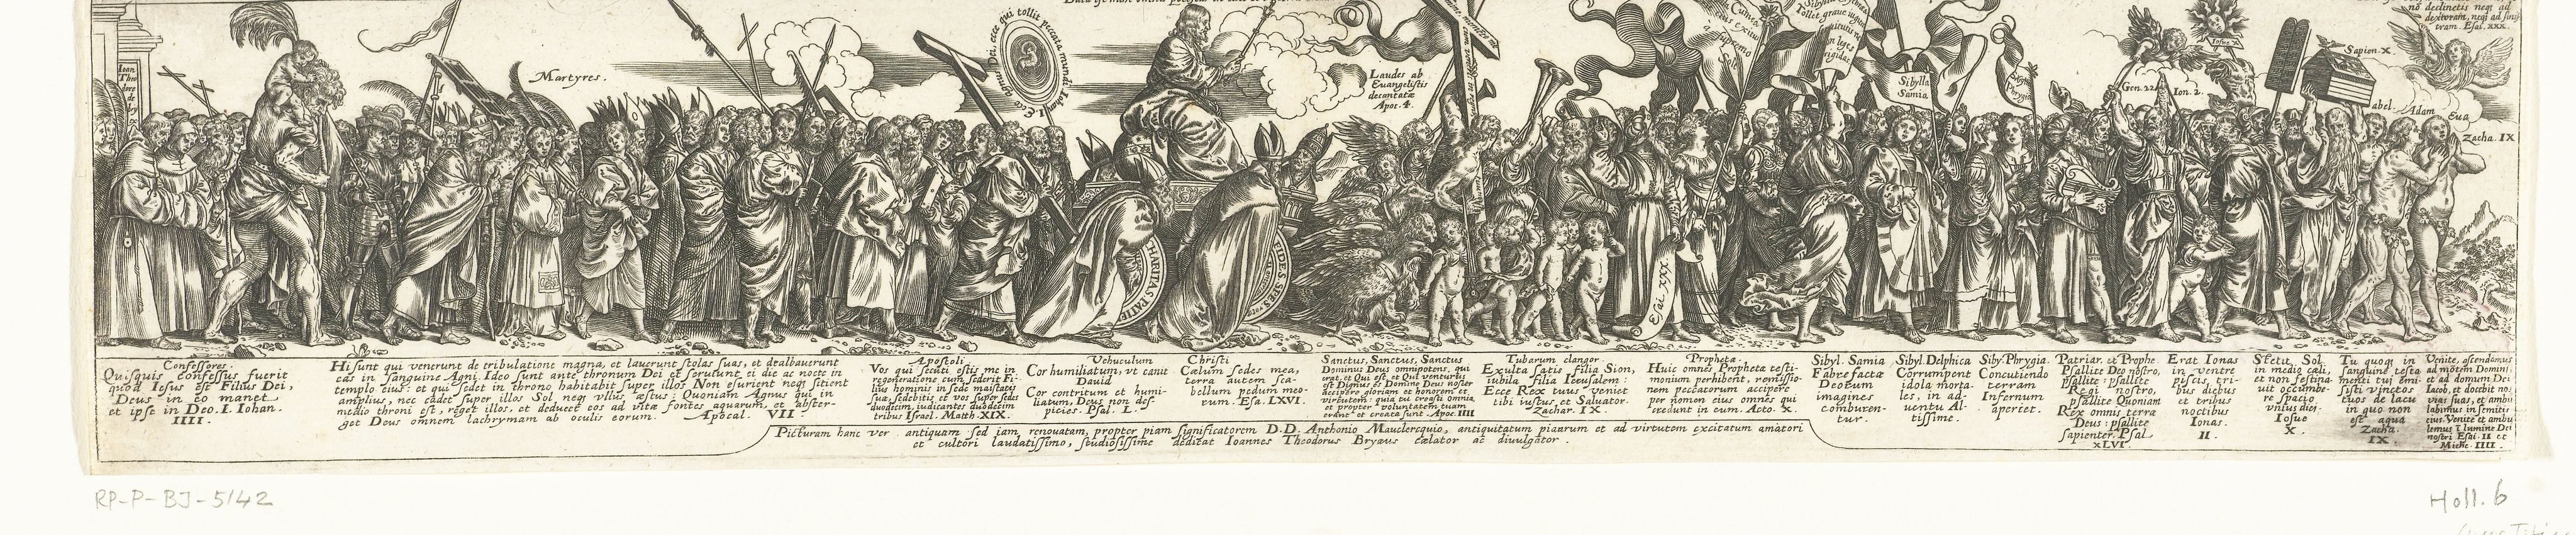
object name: print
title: De triomf van Christus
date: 1581-1623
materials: paper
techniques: engraving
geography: germany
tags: adam and eve (not in biblical context), triumphant christ, e.g. on triumphal chariot, groups of prophets, usually holding books or scrolls (isaiah, jeremiah, ezekiel, daniel, hosea, joel, amos, obadiah, jonah, micah, nahum, habakkuk, zephaniah, haggai, zechariah, malachi)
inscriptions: collector's mark: Lugt 240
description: Triomfstoet waarin Christus zit op een zegewagen, die wordt geduwd door de vier kerkvaders. De stoet wordt geopend door Adam en Eva, waarachter Noë, David, andere koningen, de Sybillen en de profeten. Johannes de Doper draagt het kruis. Achter hem de symbolen van de evangelisten. De triomfwagen van Christus wordt gevolgd door de apostelen, martelaren en heiligen (zoals Christoffel) en afgesloten door monniken. Met onderschrift en uitleg in het Latijn.